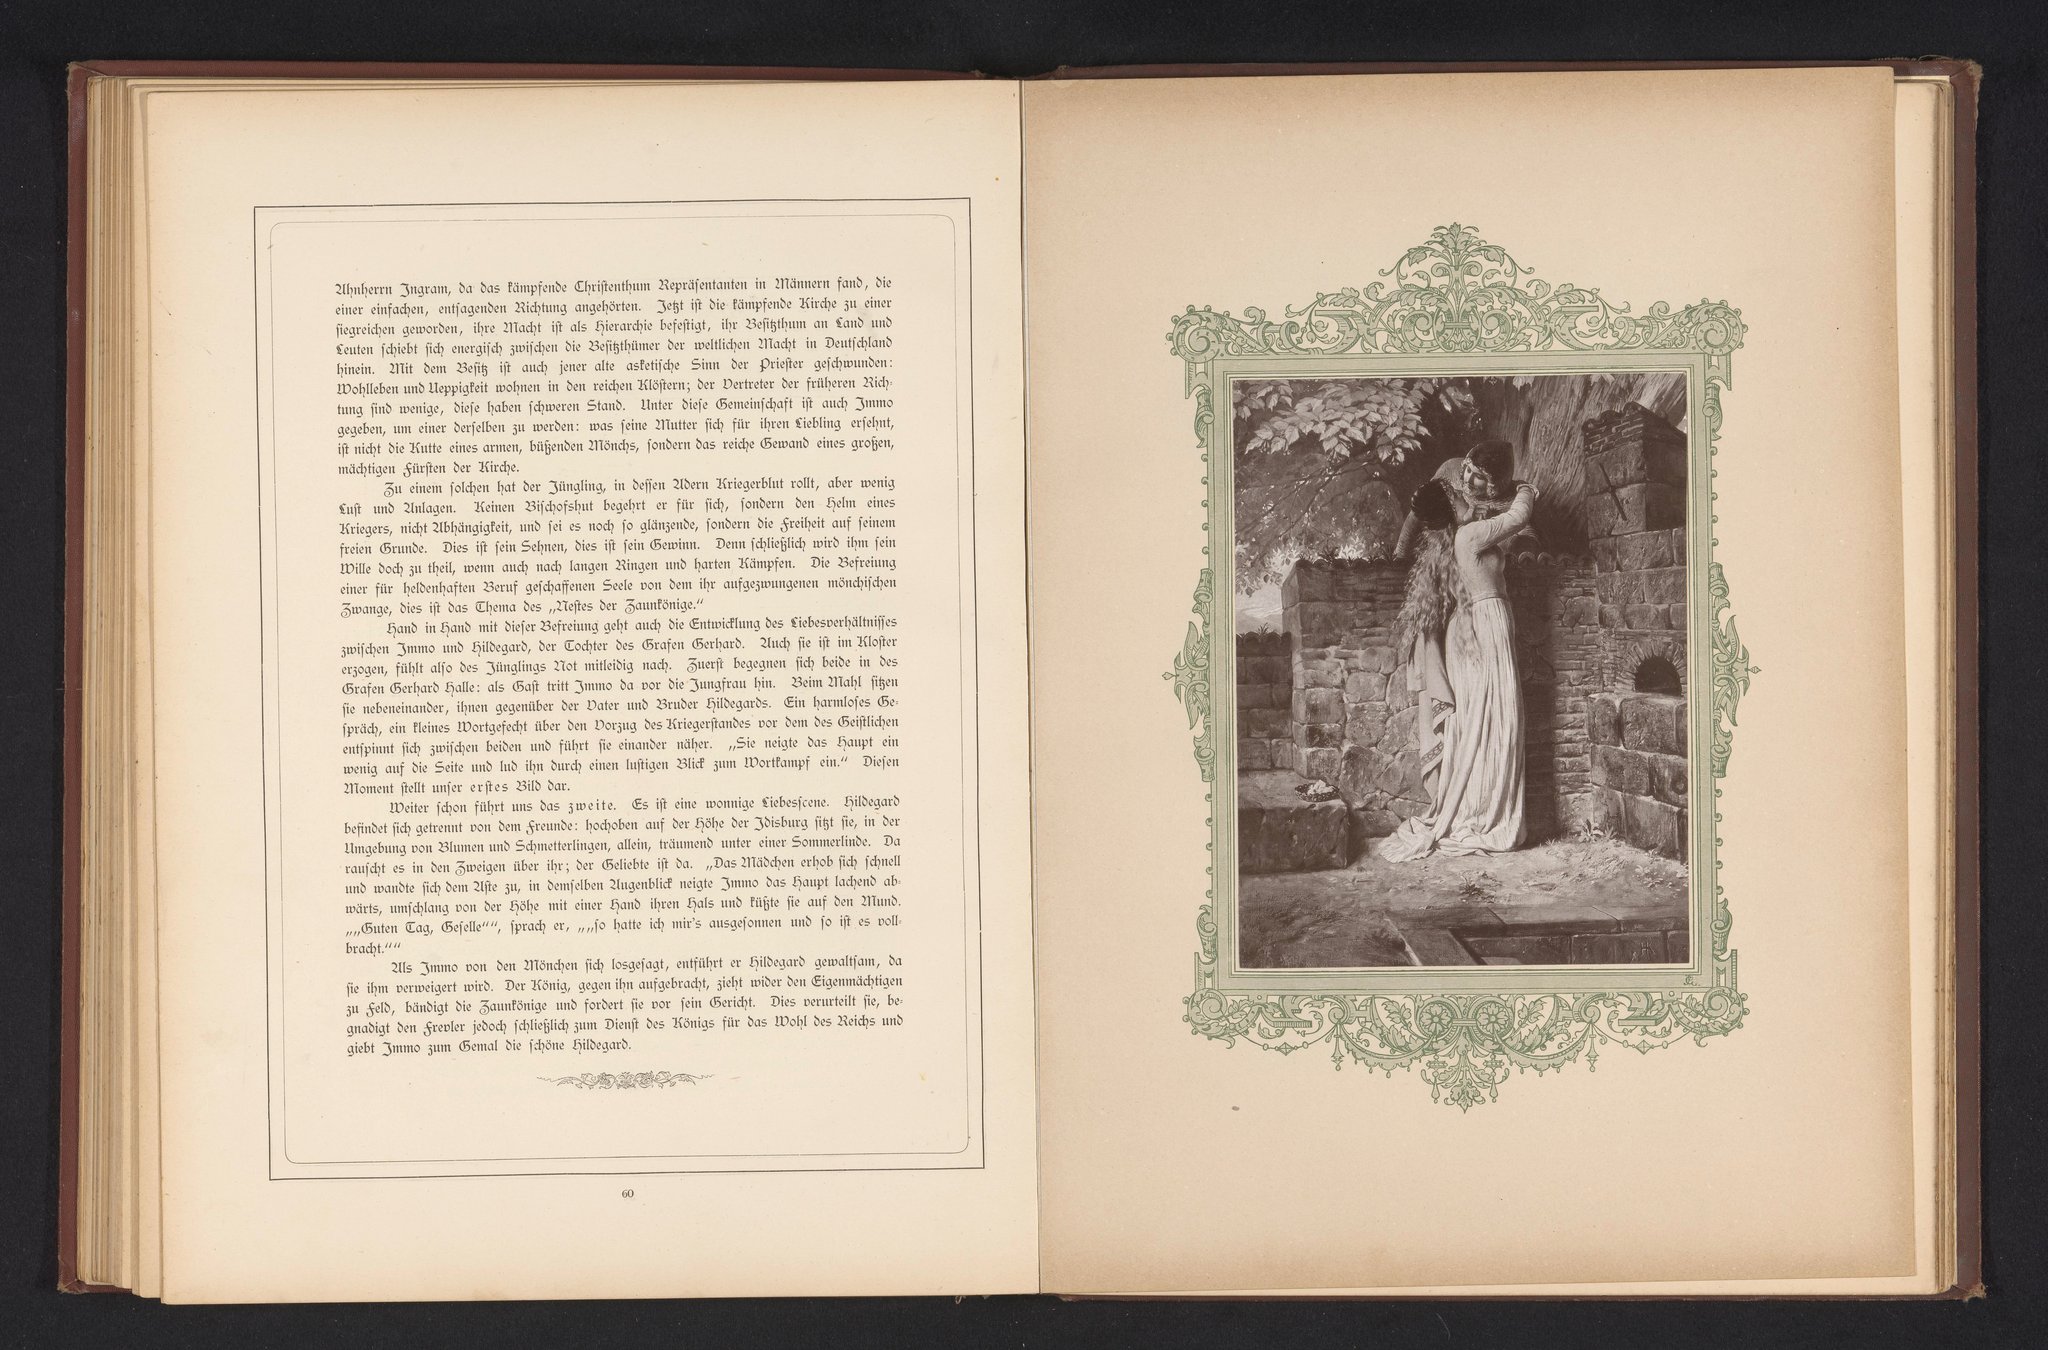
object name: photomechanical print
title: Fotoreproductie van een schilderij voorstellende een scene met Irmgard en Immo tijdens een ontmoeting uit Die Ahnen door Gustav Freytag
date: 1877-1882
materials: paper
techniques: photograph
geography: germany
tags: lovers' meeting, couple of lovers